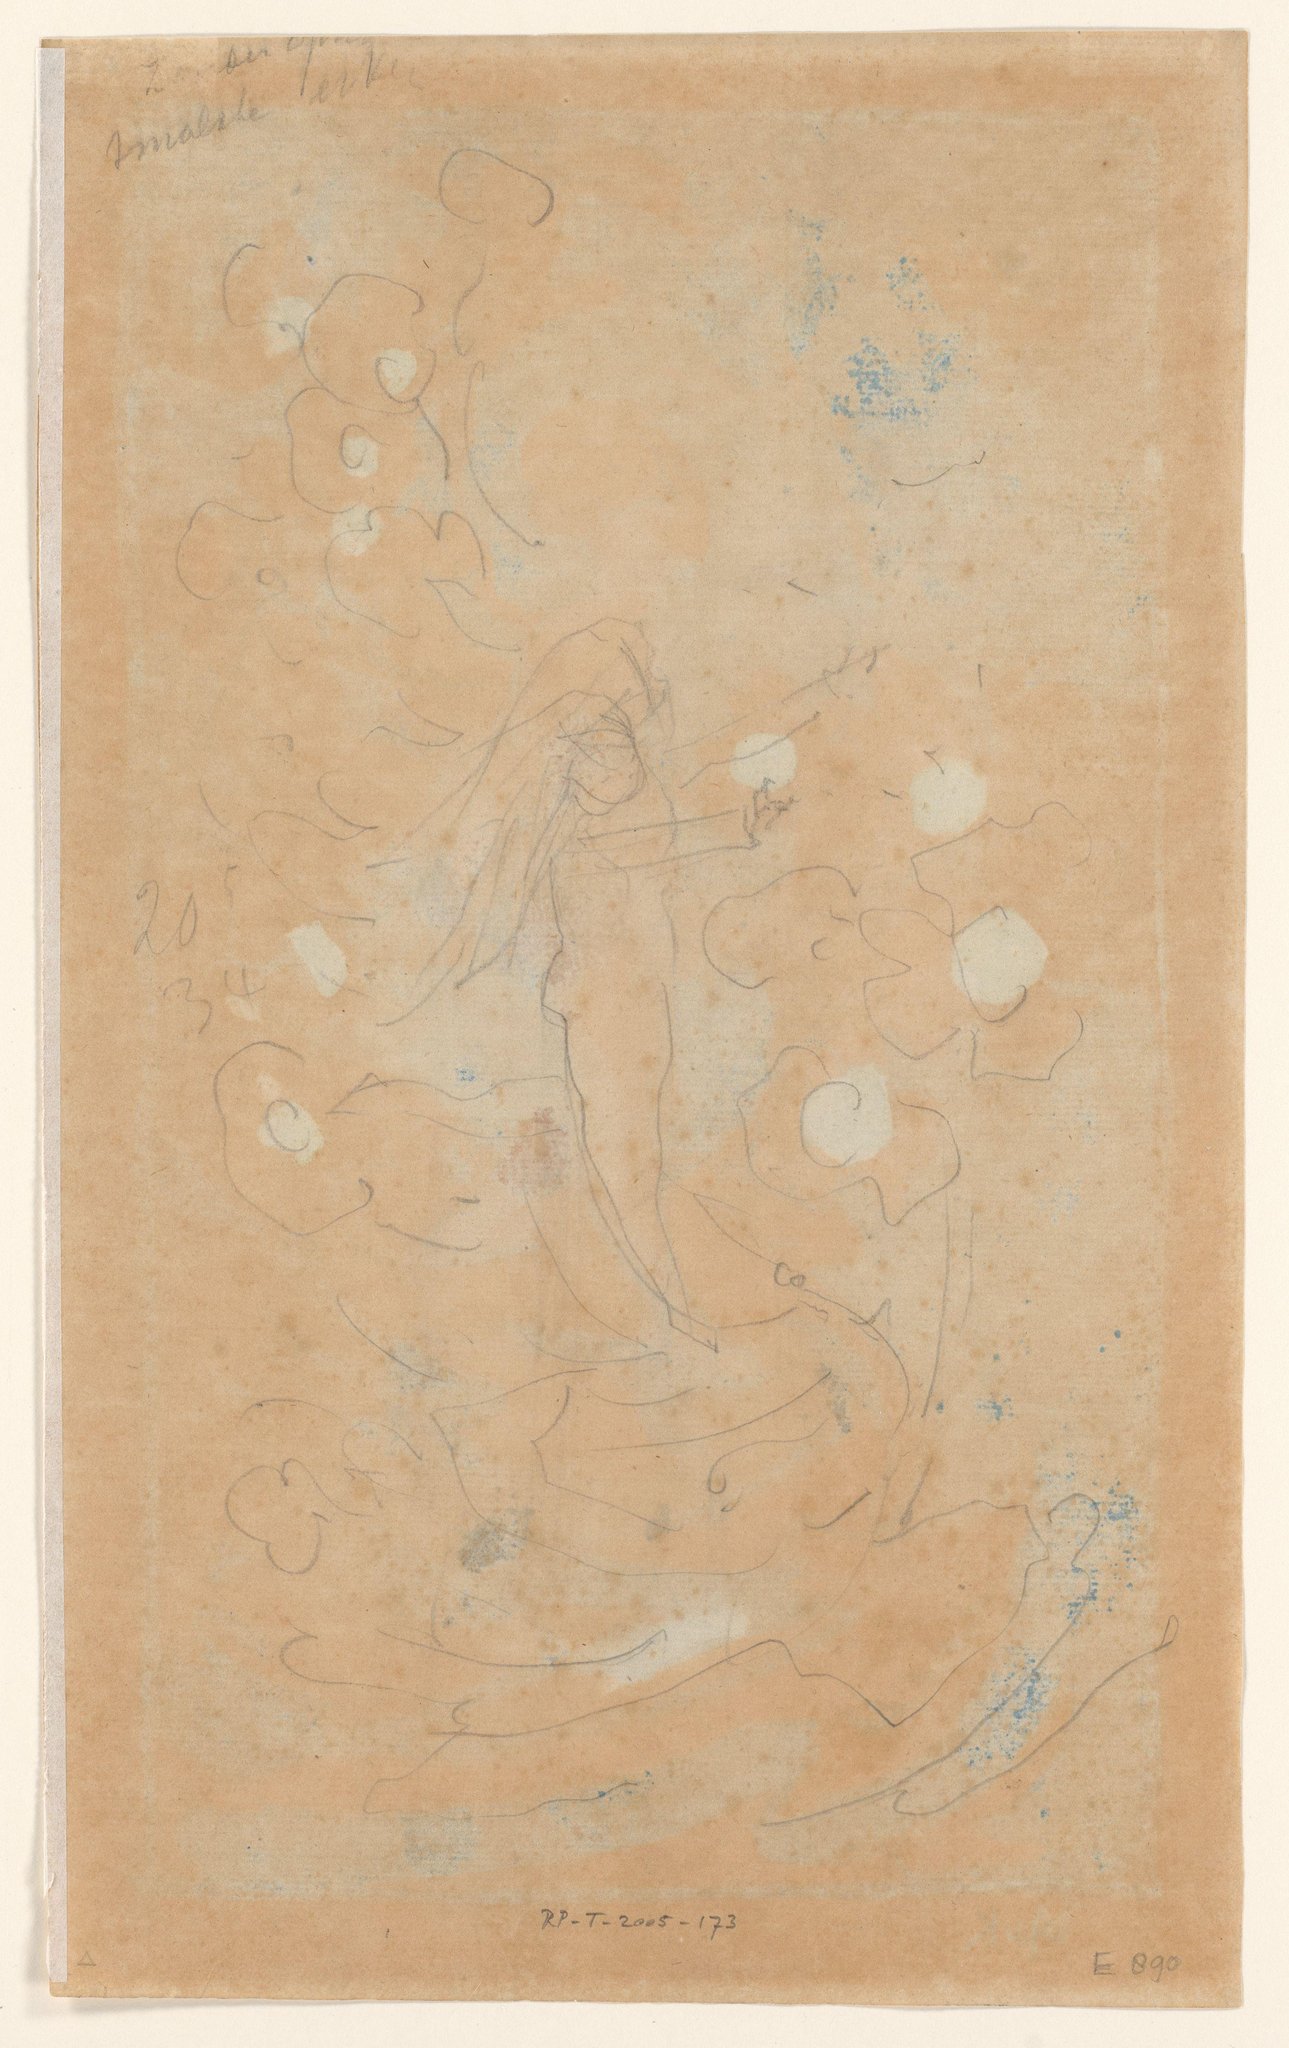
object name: boekillustratie ontwerp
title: Kleine Johannes en Windekind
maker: willem van konijnenburg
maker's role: draughtsman, painter, print maker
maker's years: 1868-1943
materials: paper, pencil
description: Boekillustratie voor Frederik van Eeden, De kleine Johannes (gepubliceerd in 1887, maar niet met deze illustratie).